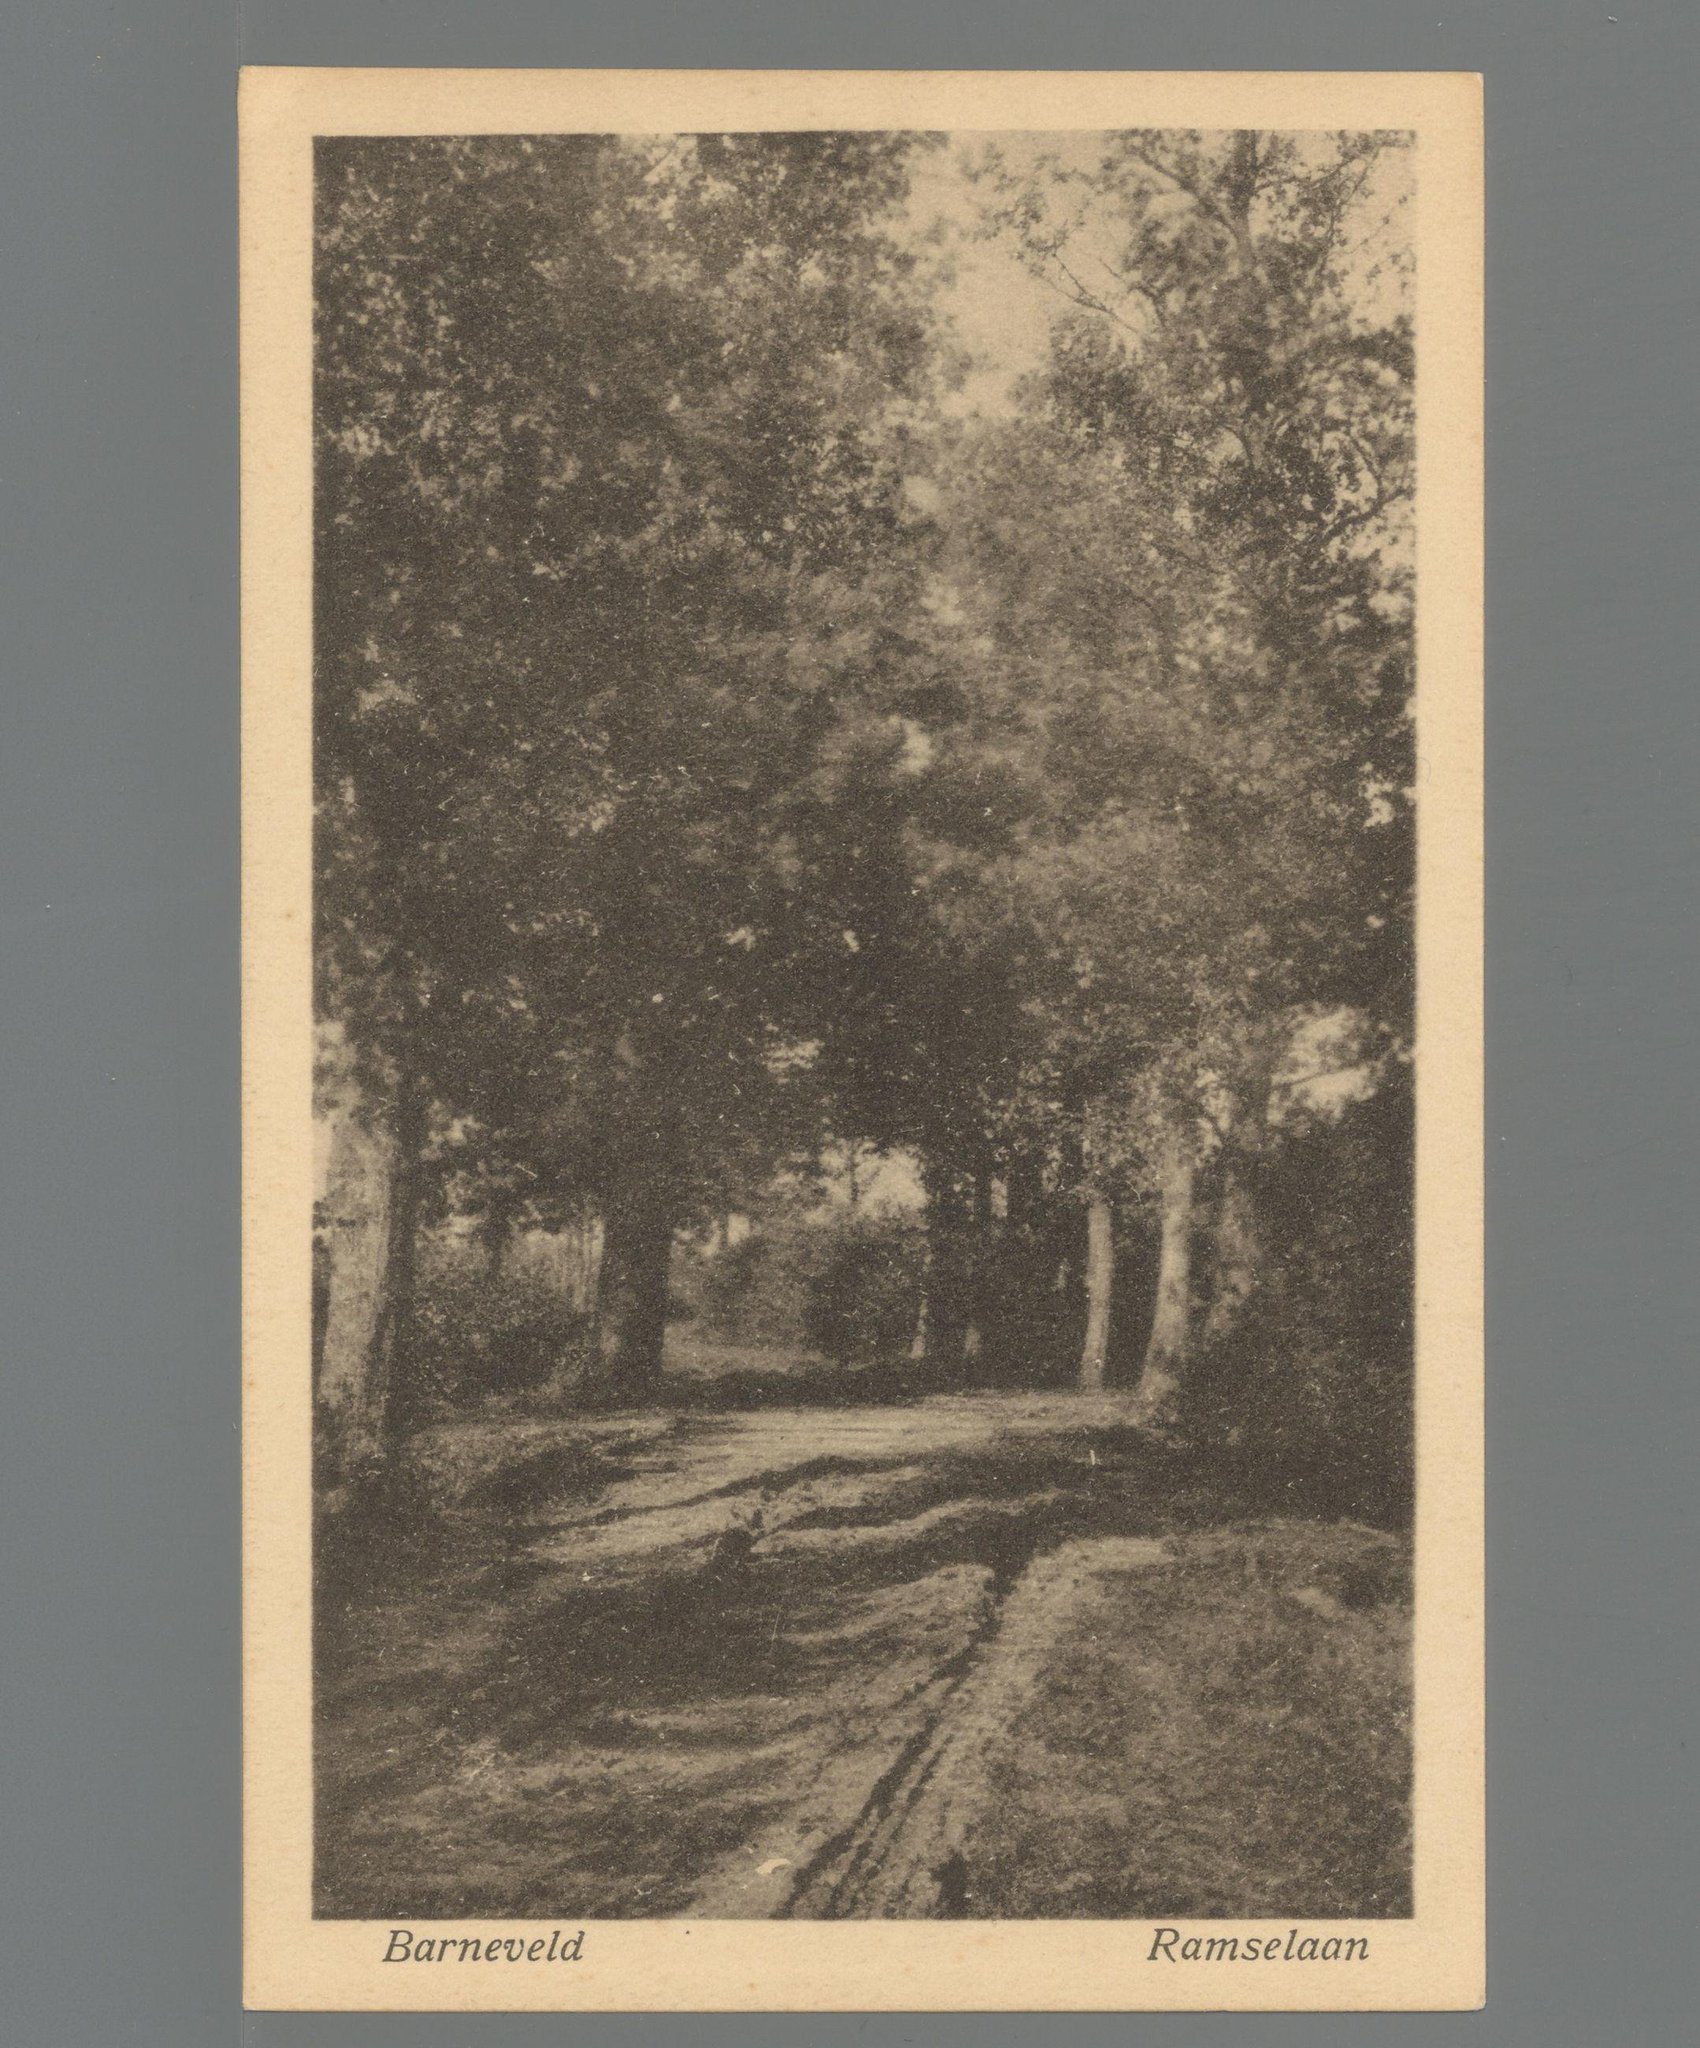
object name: photomechanical print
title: Barneveld. Ramselaan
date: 1913-1930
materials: cardboard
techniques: photograph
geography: barneveld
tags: road, path